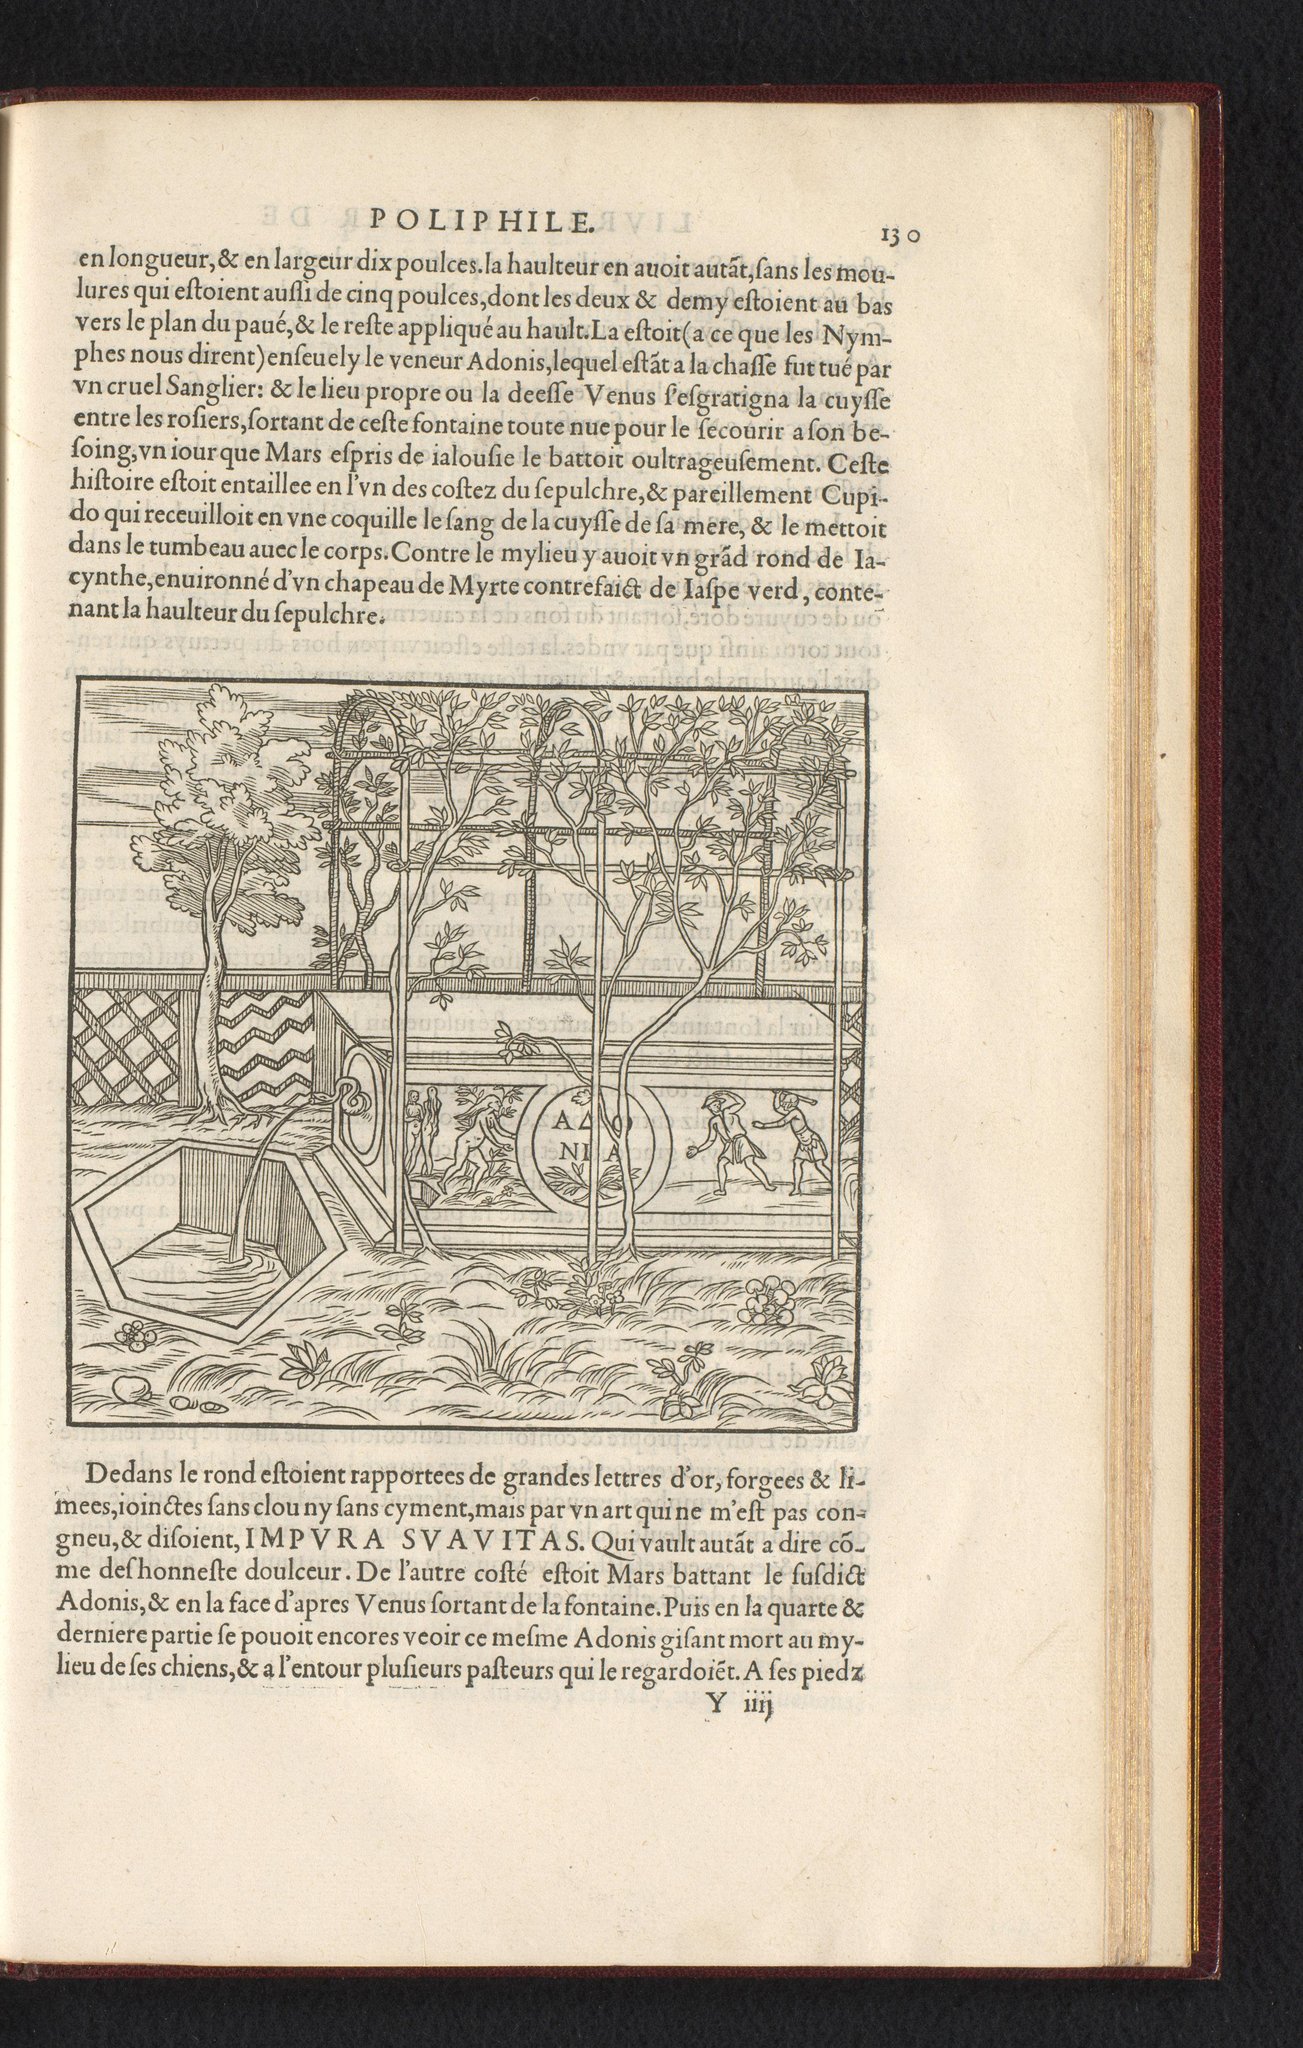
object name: print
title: Fontein in een tuin met mythologische decoratie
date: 1546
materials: paper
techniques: letterpress printing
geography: paris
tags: garden fountain, (scenes from) specific works of literature: colonna, hypnerotomachia poliphili, ornamental fountain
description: Prent uit: Colonna, Francesco. Hypnerotomachie ou discours du songe de Poliphile, deduisant comme amour le combat a l'occasion de Polia. Parijs: Jacques Kerver, 1546, recto fol. 130.